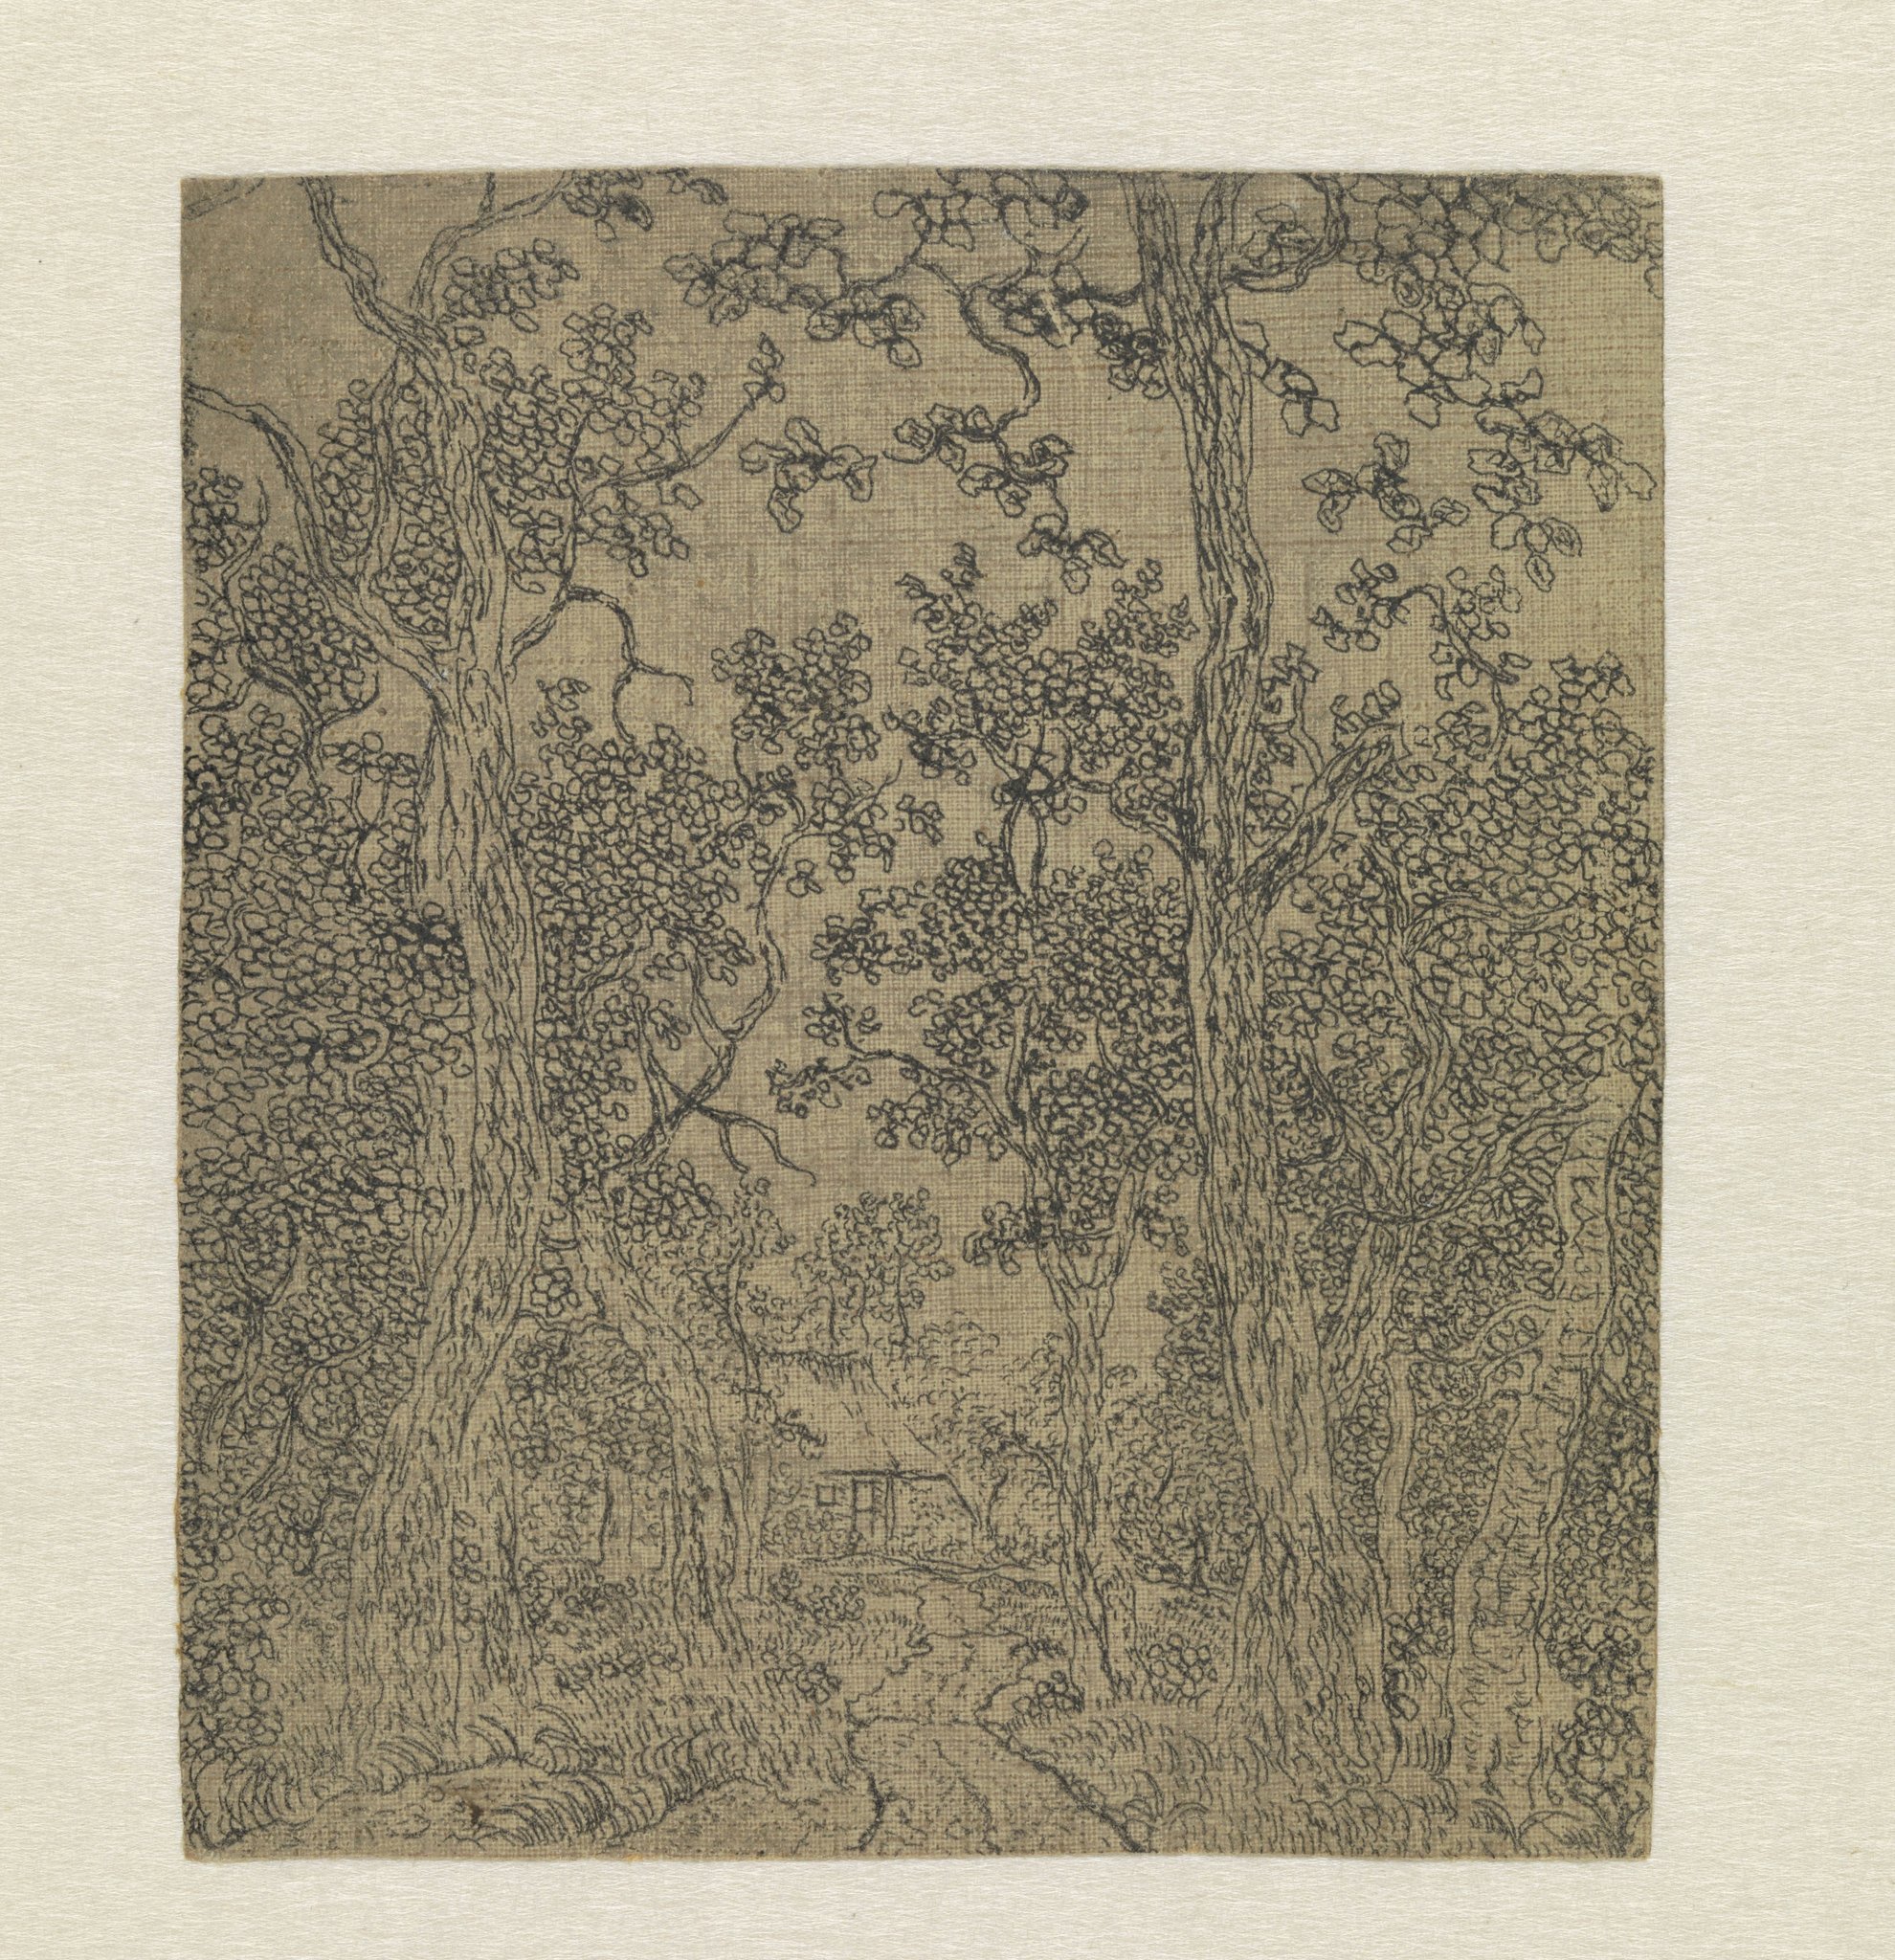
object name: print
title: Small Wooded Landscape with a Road and a House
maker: hercules segers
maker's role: draughtsman, painter, print maker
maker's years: 1589-1640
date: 1618-1622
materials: cotton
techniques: etching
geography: amsterdam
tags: road, path, forest, wood, farm or solitary house in landscape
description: Een pad door een bos, aan het einde ervan een huis.